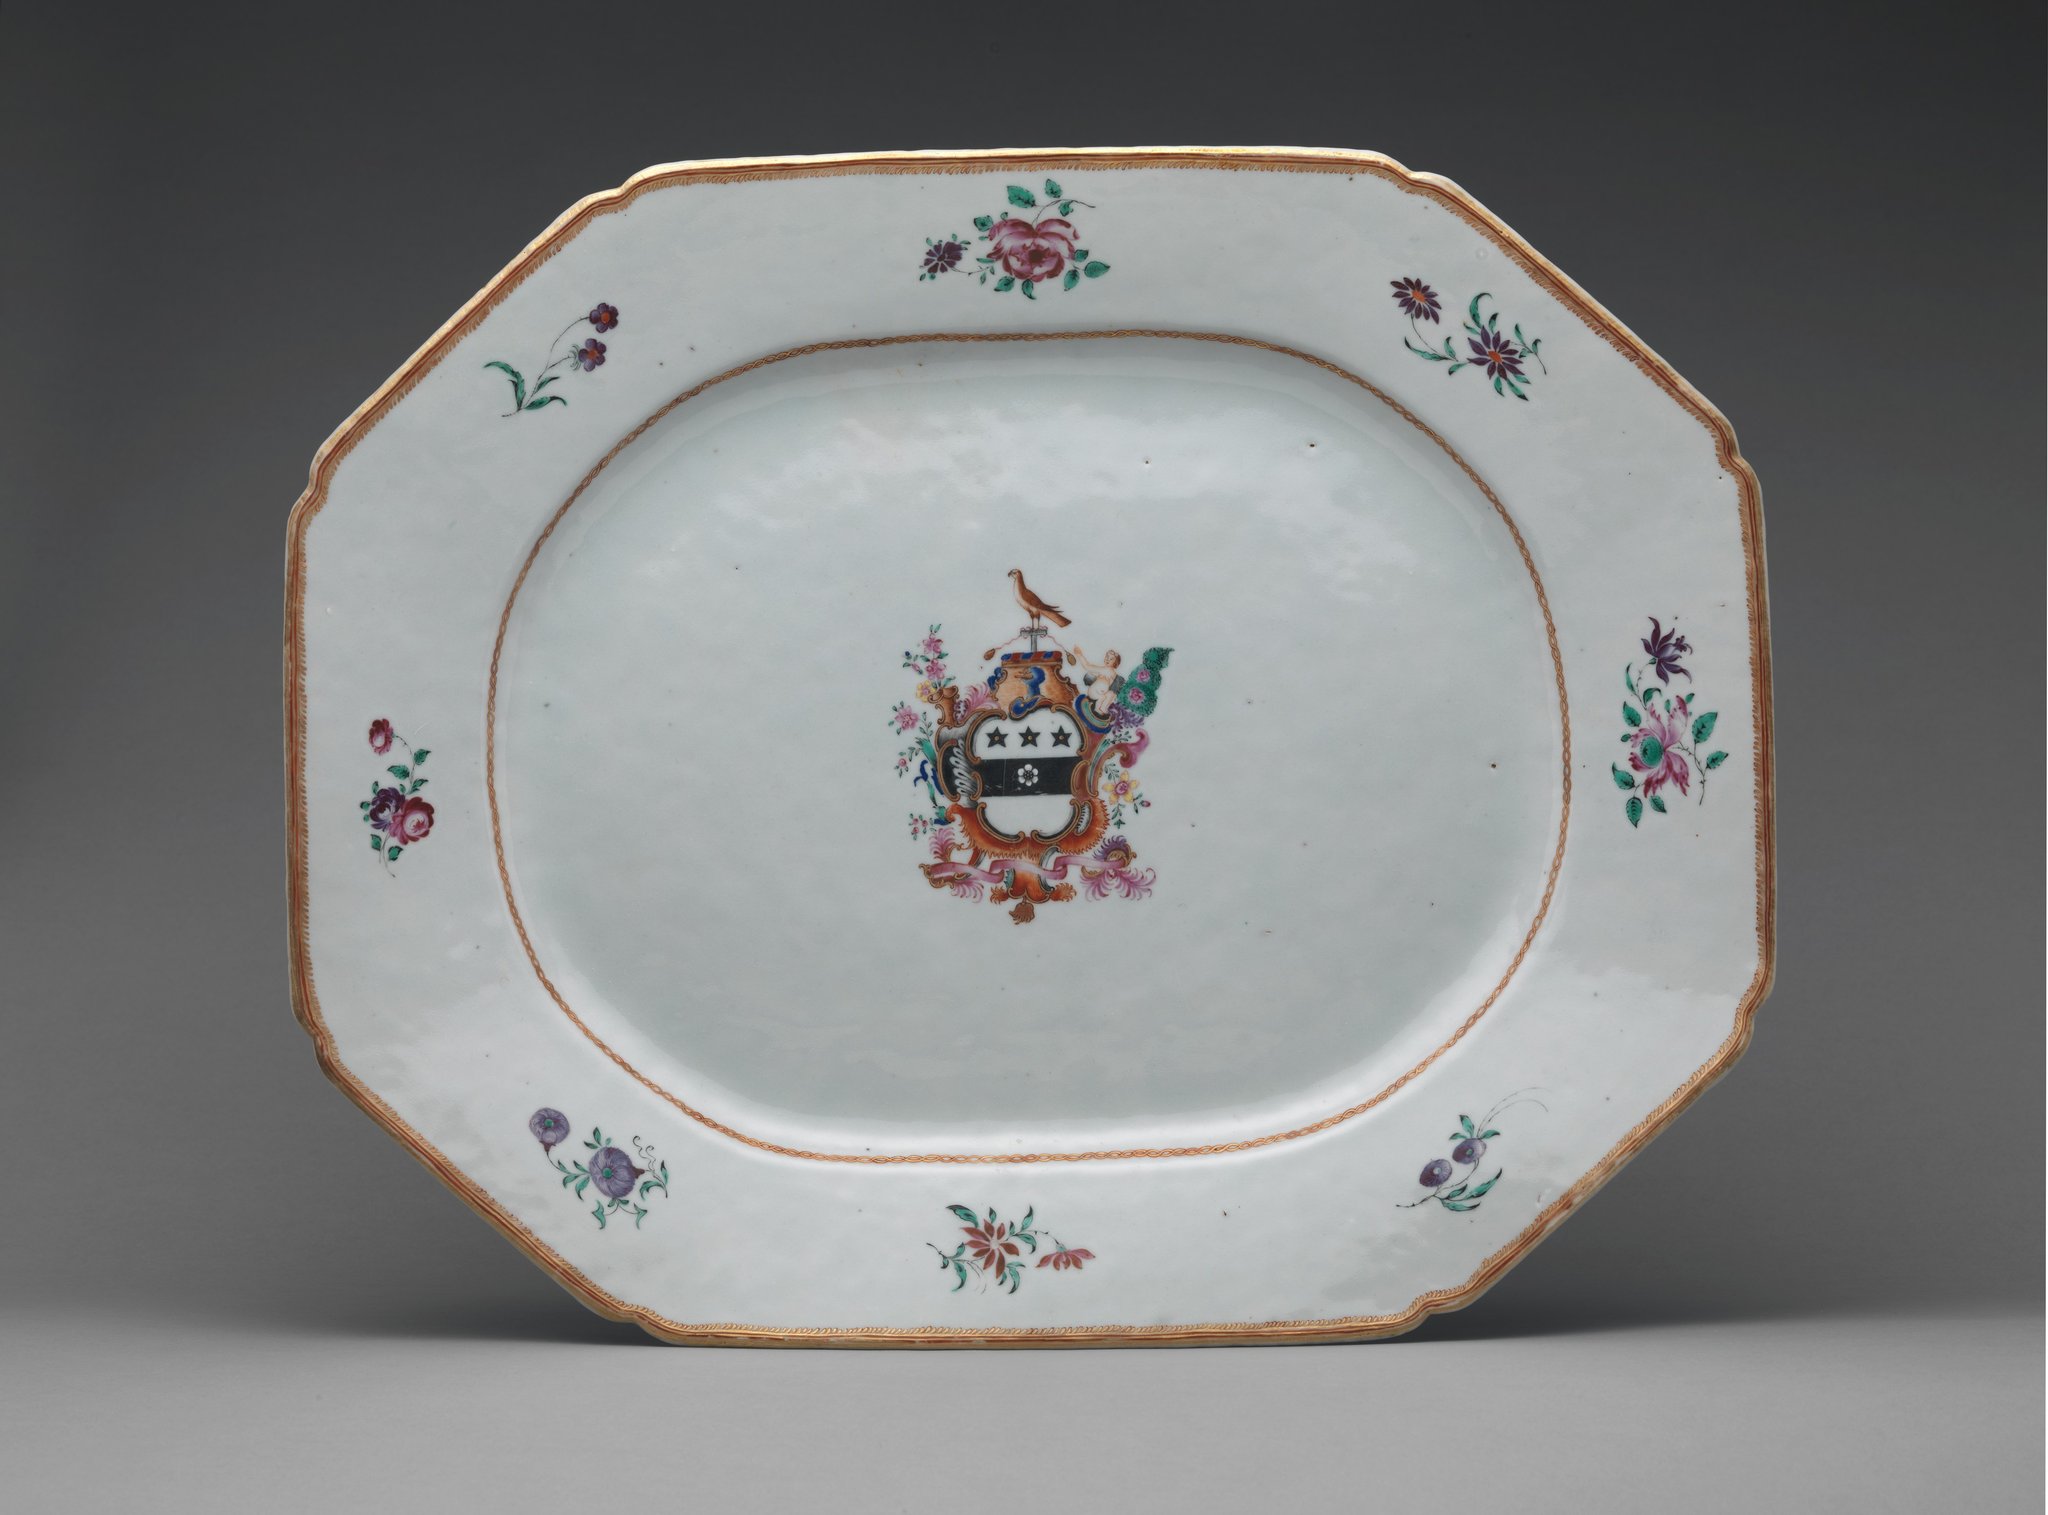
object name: platter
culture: chinese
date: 1785-1790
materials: porcelain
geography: china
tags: birds,flowers,coat of arms